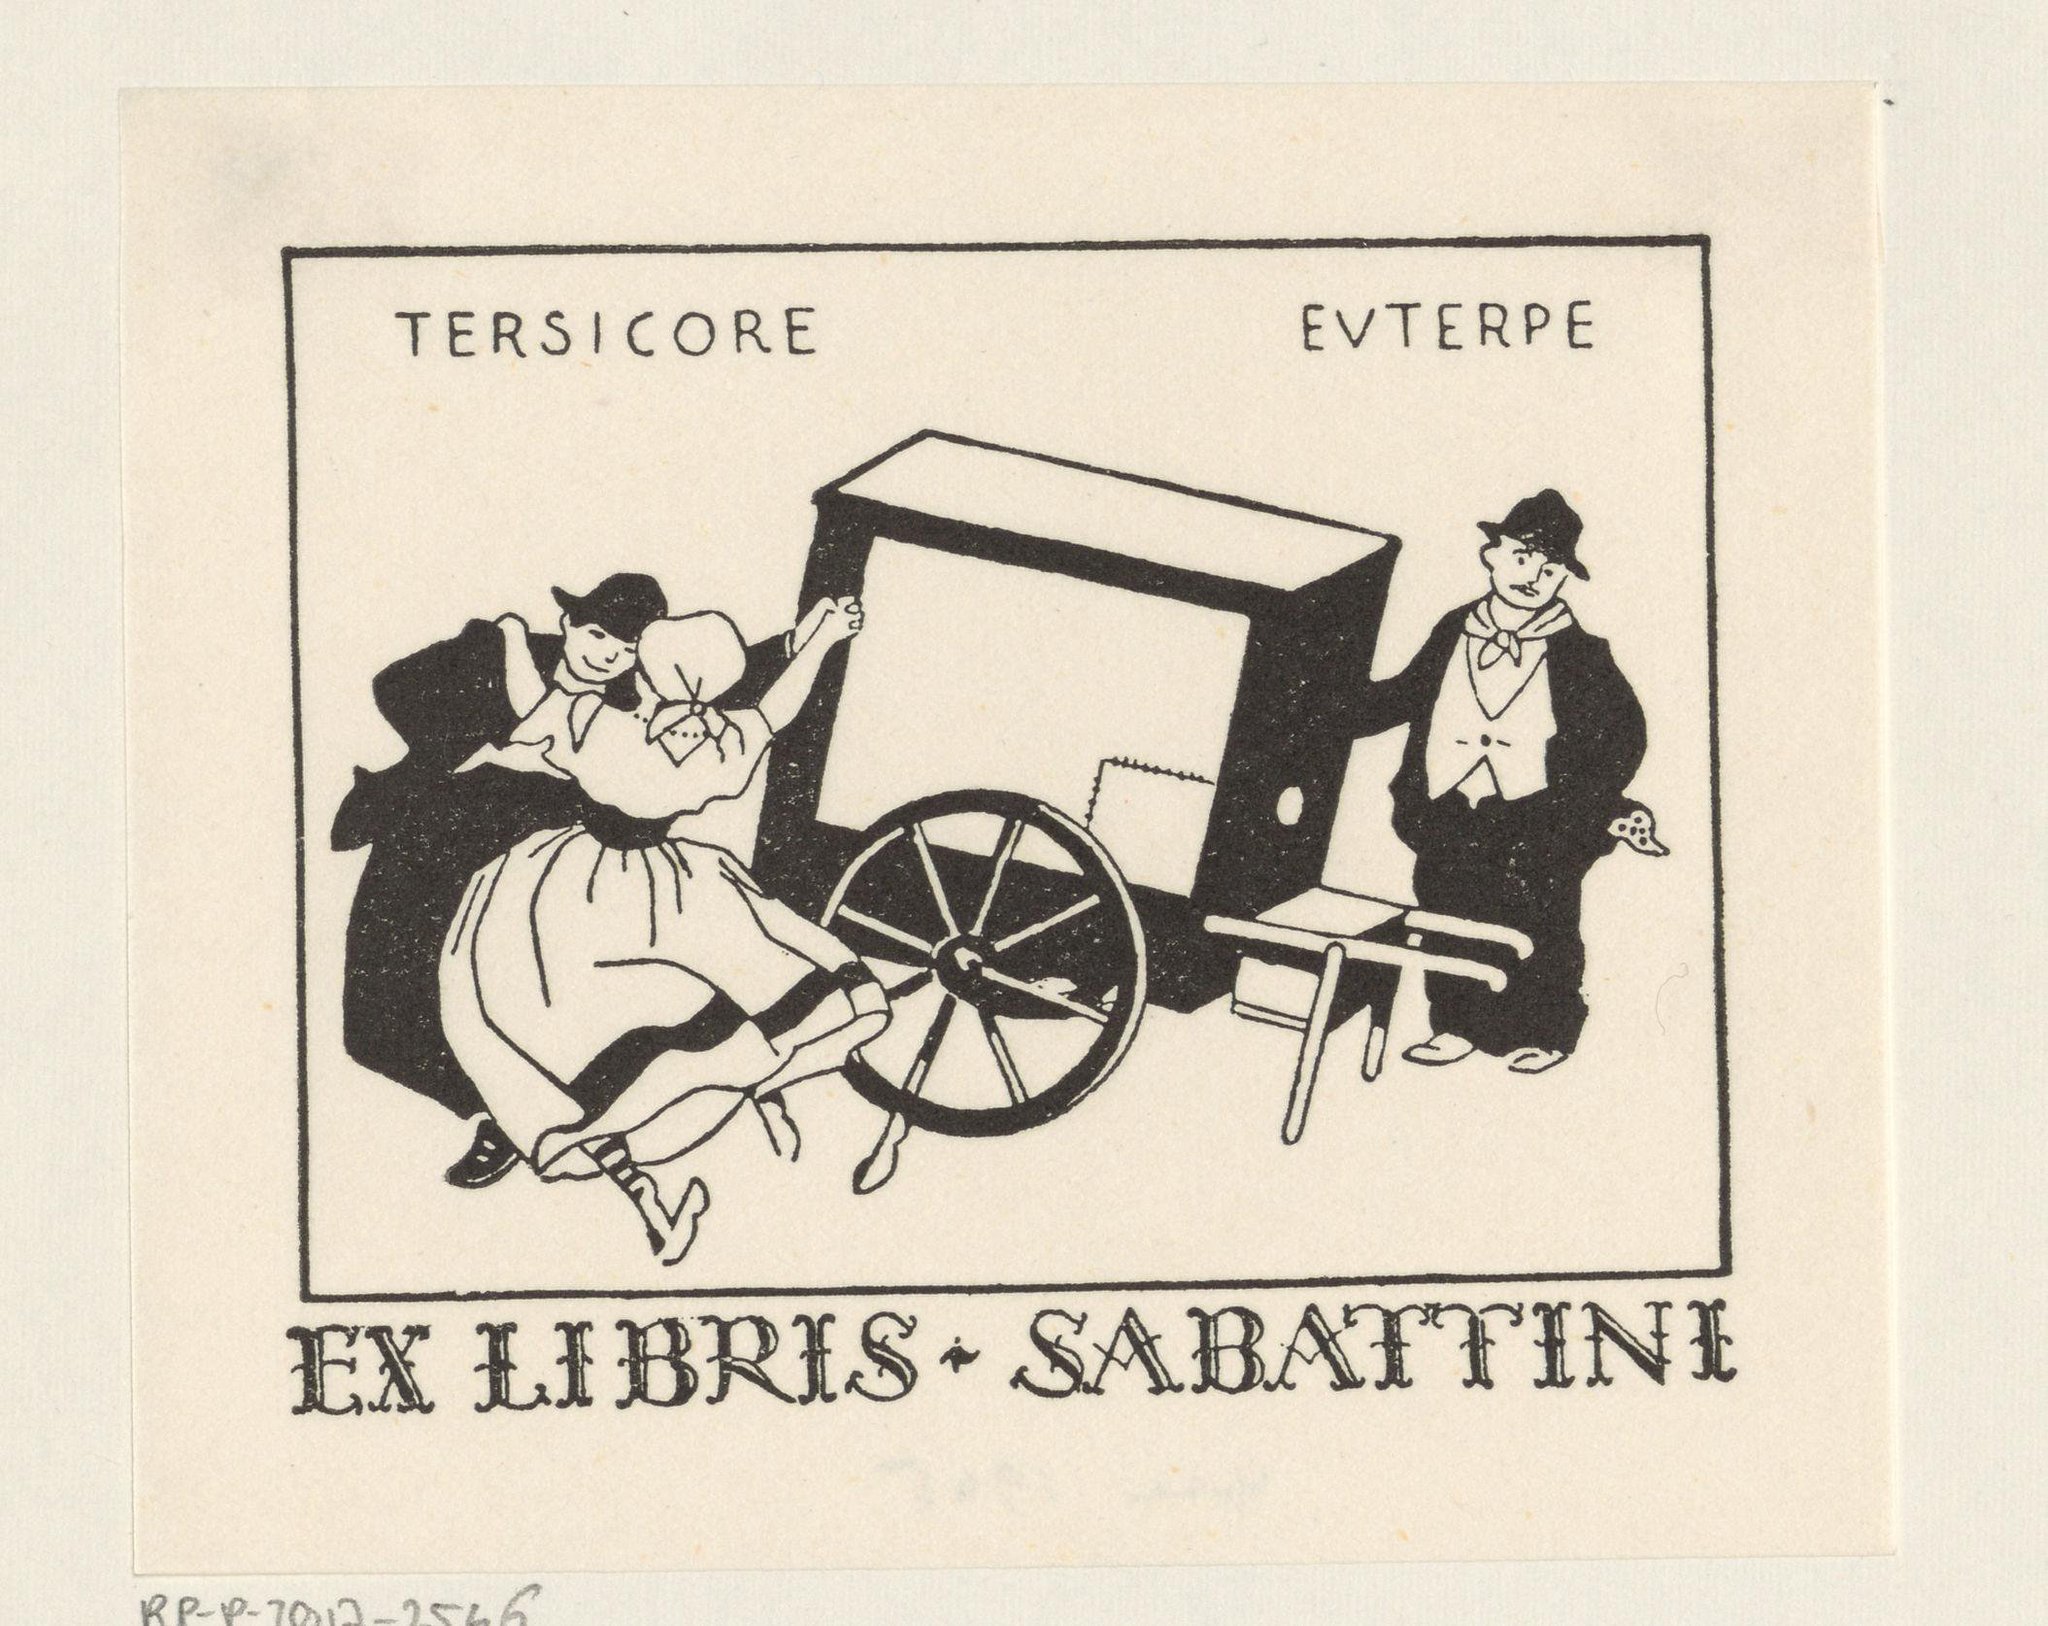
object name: bookplate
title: Teriscore Euterpe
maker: Anonymous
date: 1945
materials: paper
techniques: printing block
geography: italy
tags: gino sabattini, hand-cart, one pair dancing; man and woman dancing as a couple, folk costume, regional costume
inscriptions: inscription: ‘ipse 1945’